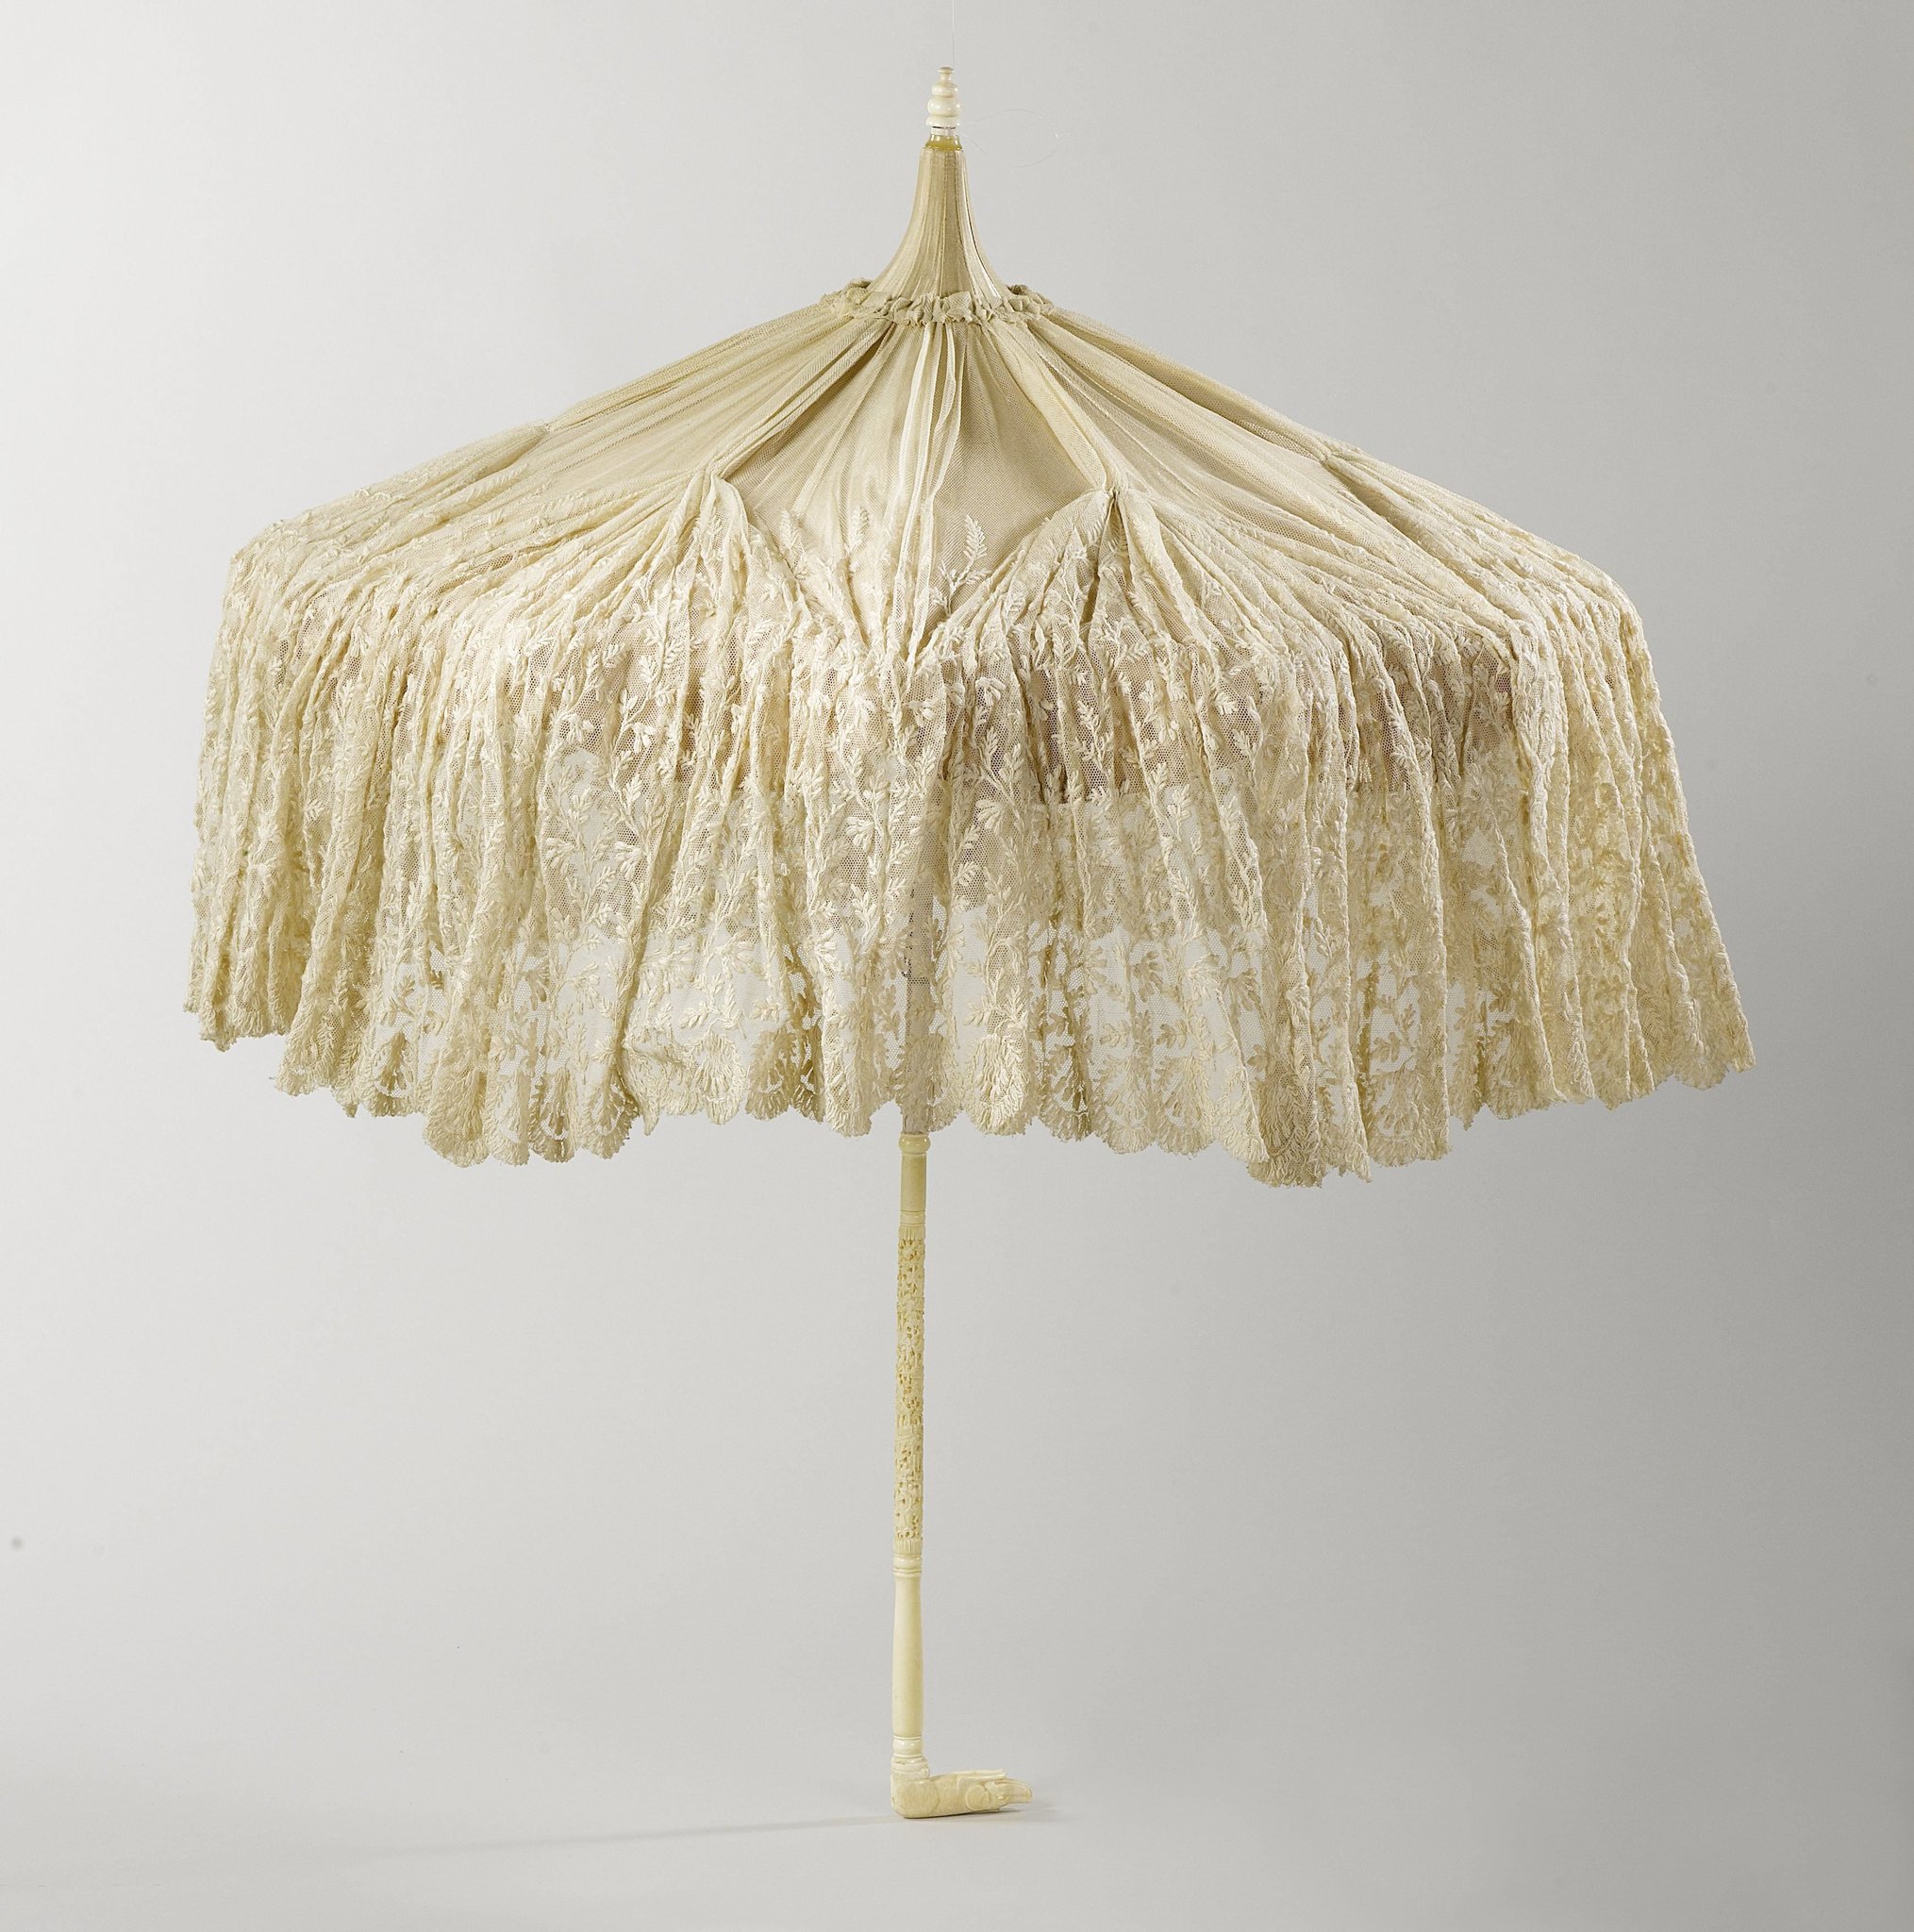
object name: parasol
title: Parasol met dek van champagnekleurige zijde en rondom afhangende machinale borduurwerk op tule, stok van wit geverfd esdoornhout, handvat van ivoor in vorm van liggende hond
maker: Anonymous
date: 1900-1930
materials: ivory, wood, silk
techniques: cutting, embroidered, weave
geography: france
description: Parasol met dek van champagnekleurige zijde met geschulpte rand en van boven in een punt eindigend. Machinale borduurwerk is er boven overheen geplooid en hangt in een brede strook af. De stok is wit beschilderd, de punt is van ivoor met Chinees snijwerk. Het handvat in de vorm van een liggende hond.